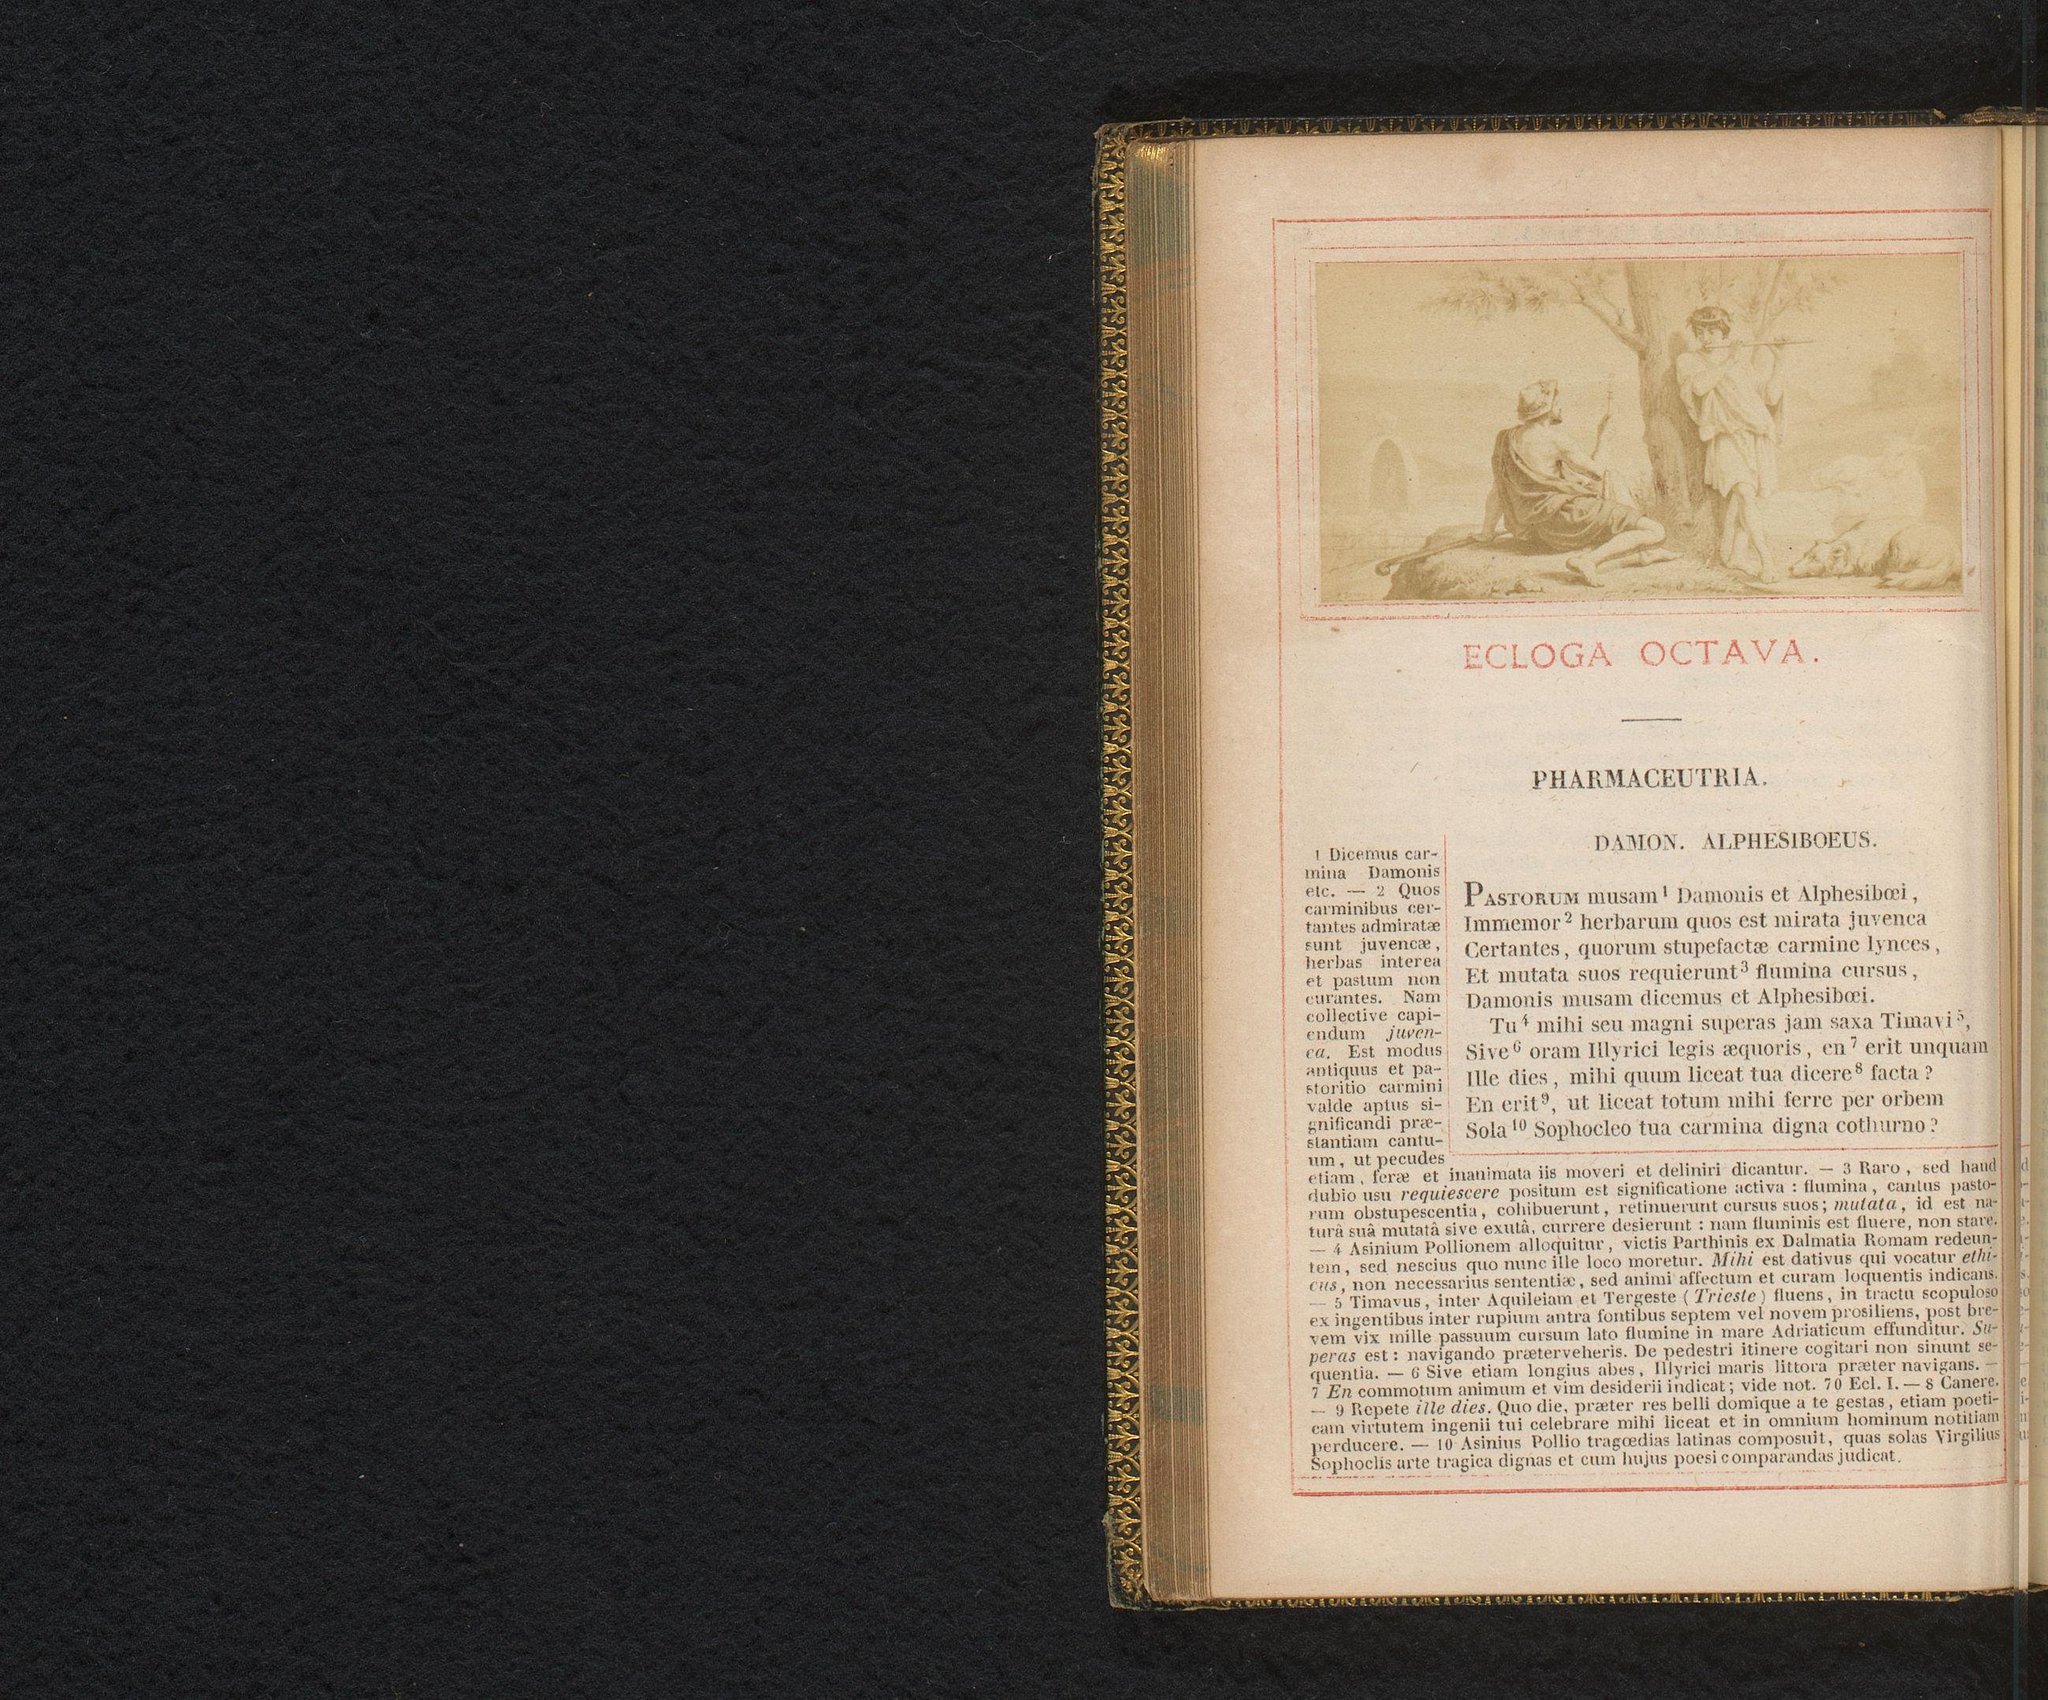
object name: reproduction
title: Fotoreproductie van een schilderij van Damon en Alphesiboeus met fluiten, scène uit Virgilius' Bucolica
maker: Anonymous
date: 1853-1858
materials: paper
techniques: albumen print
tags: herding, herdsman, herdswoman, shepherd, shepherdess, cowherd, etc., flute, aulos, tibia